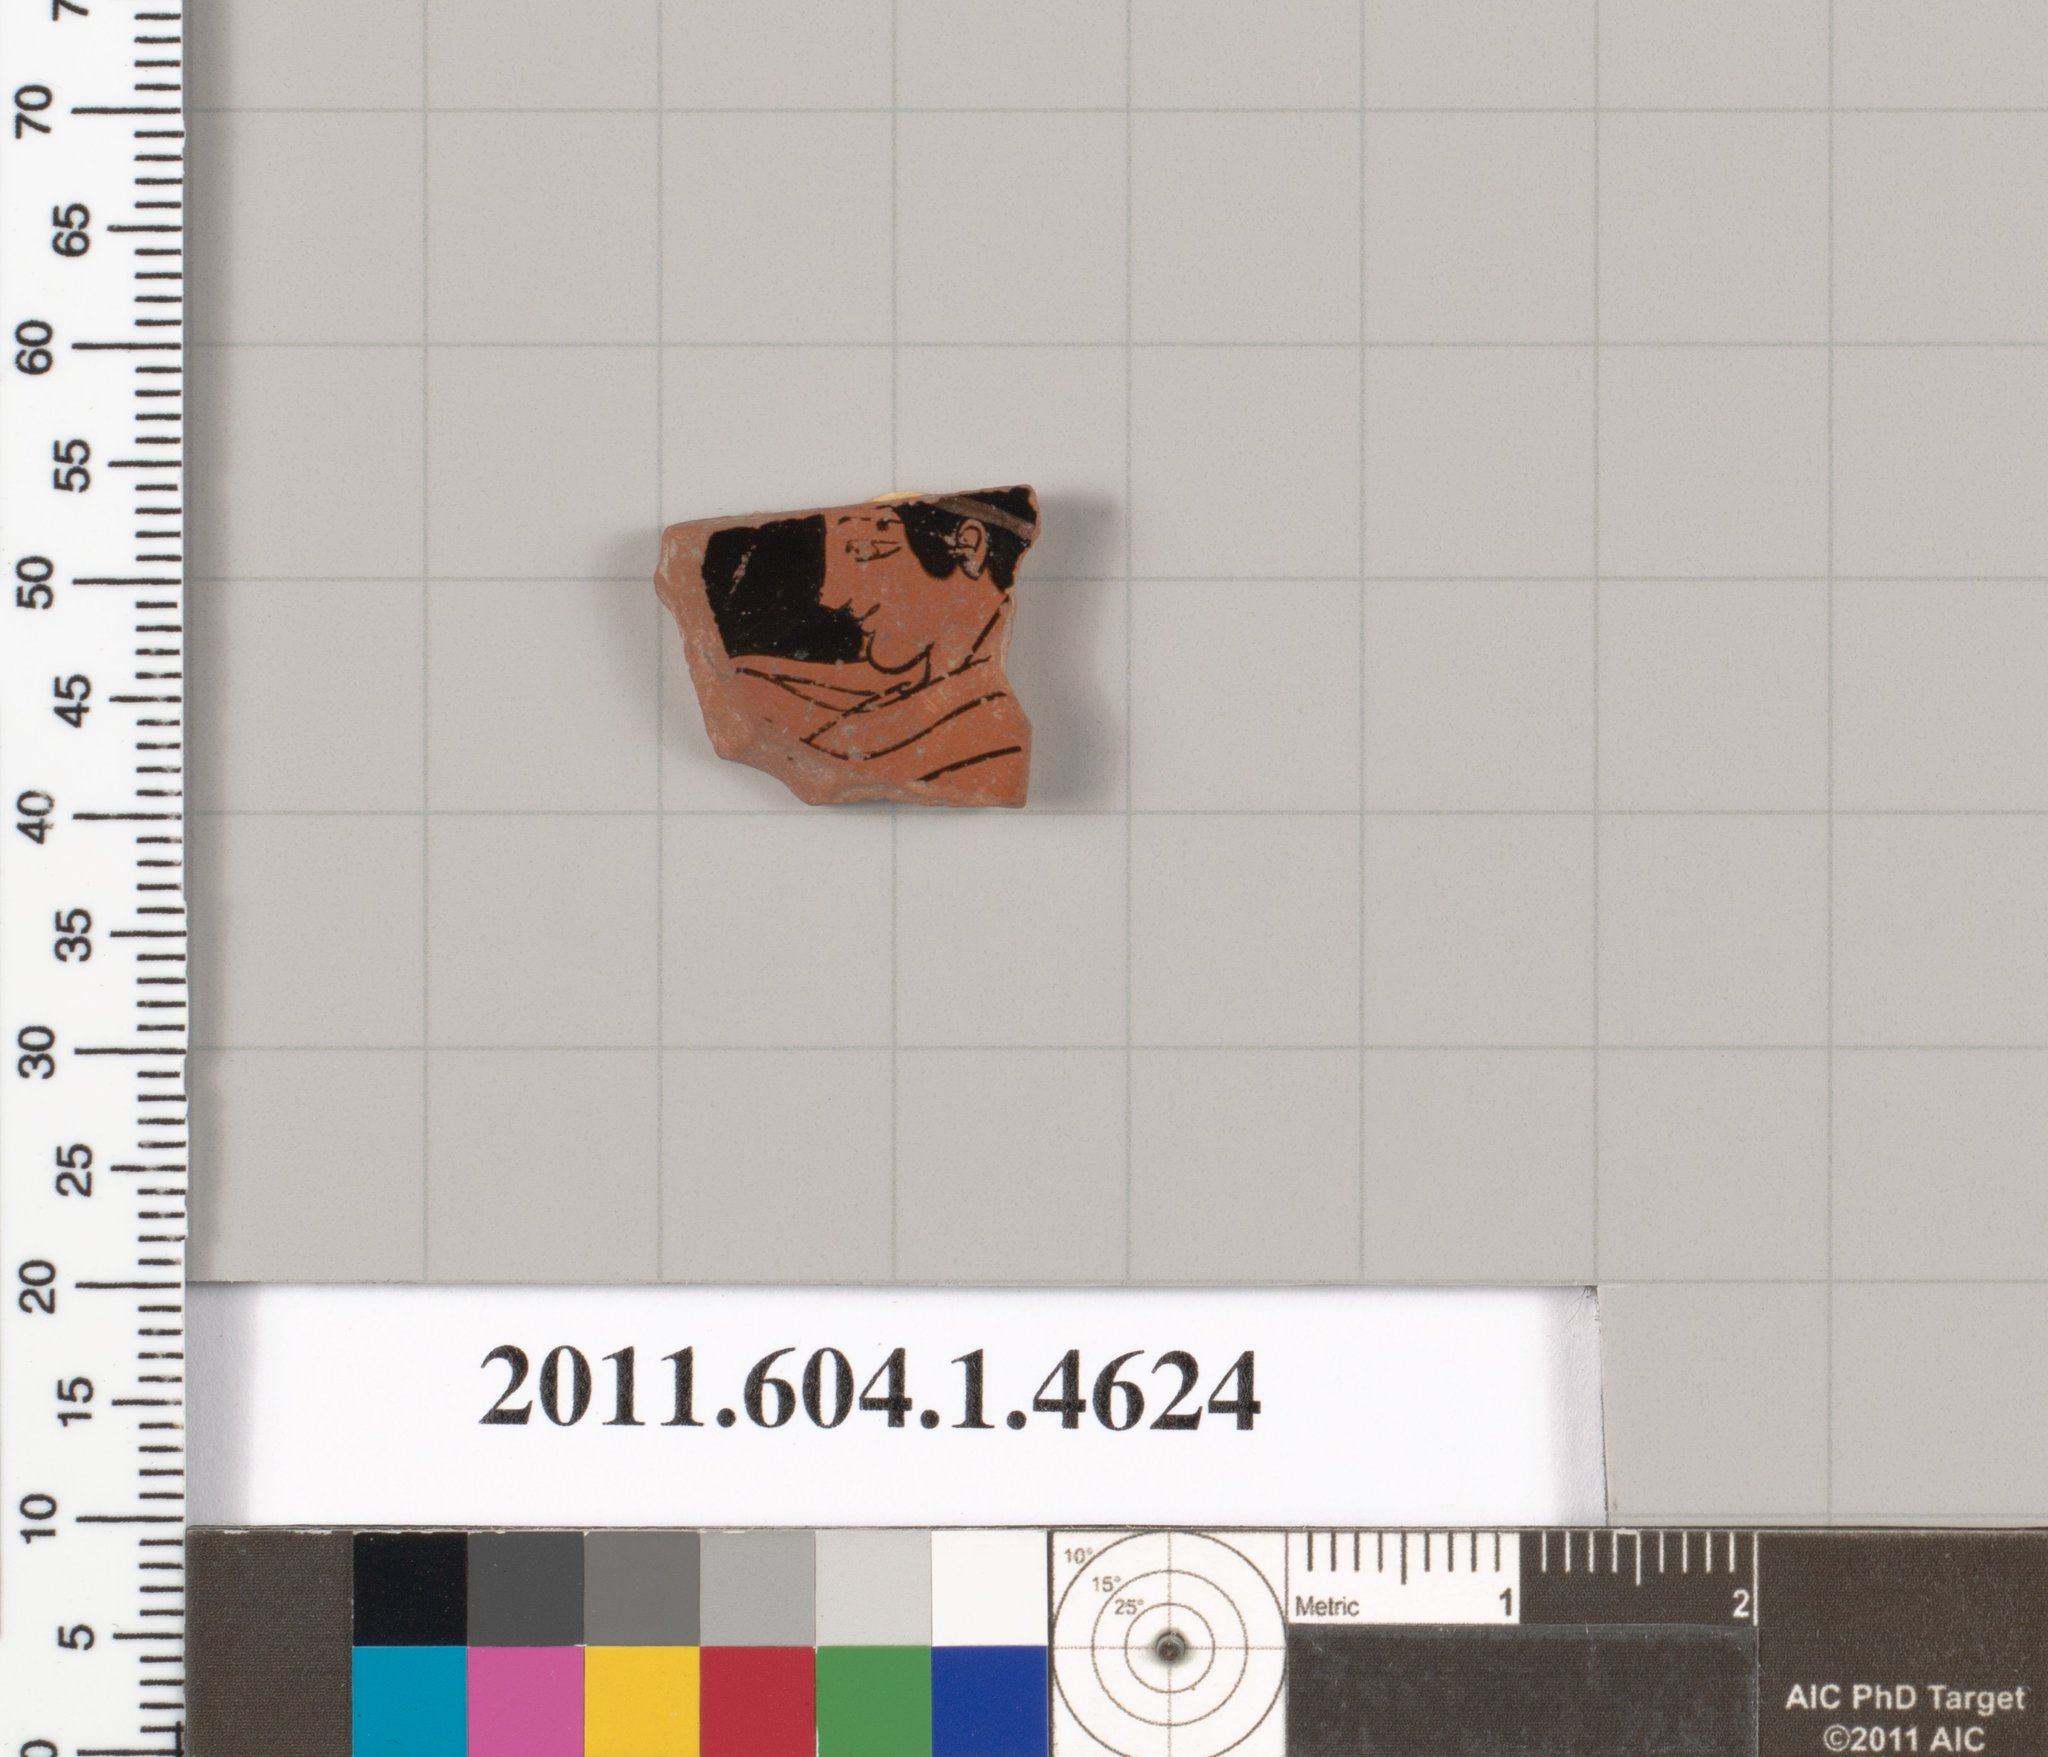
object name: kylix fragment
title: Terracotta fragment of a kylix (drinking cup)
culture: greek, attic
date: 480-470 BCE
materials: terracotta